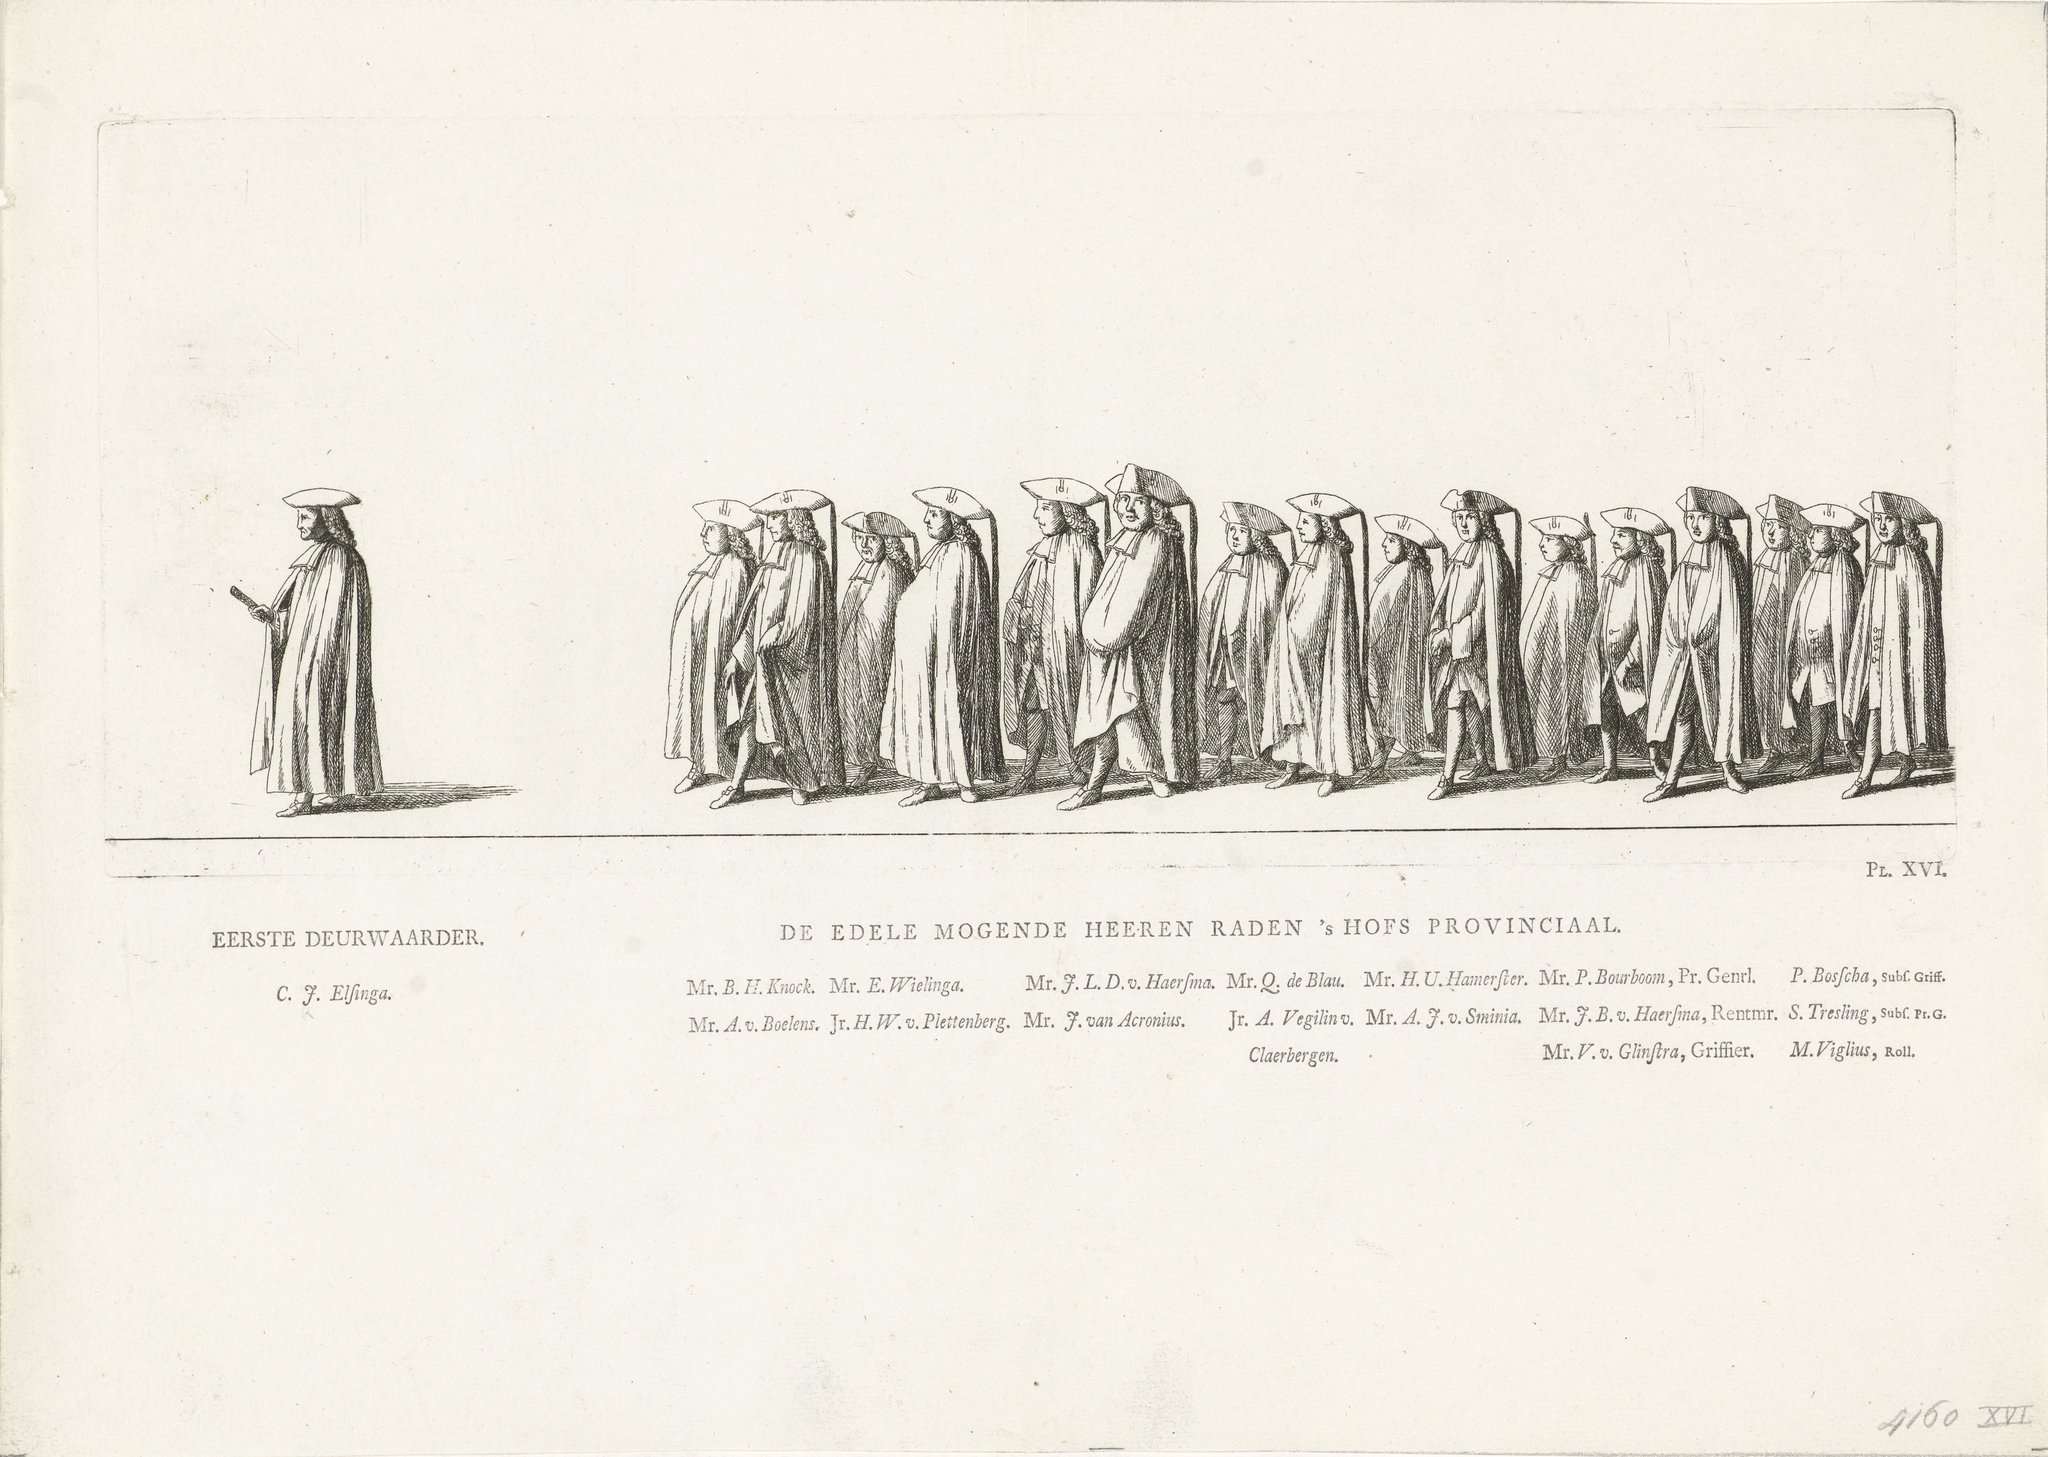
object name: print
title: Leden van het Hof van Friesland in de begrafenisstoet van prinses Maria Louise, 1765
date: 1765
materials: paper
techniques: etching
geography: leeuwarden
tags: cortege, funeral procession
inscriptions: date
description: Leden van het Hof van Friesland. Gemerkt rechtsonder: Pl. XVI. Op het blad onder de plaat de namen van personen in de stoet. Onderdeel van de serie platen van de begrafenis van prinses Maria Louise te Leeuwarden op 13 juni 1765.